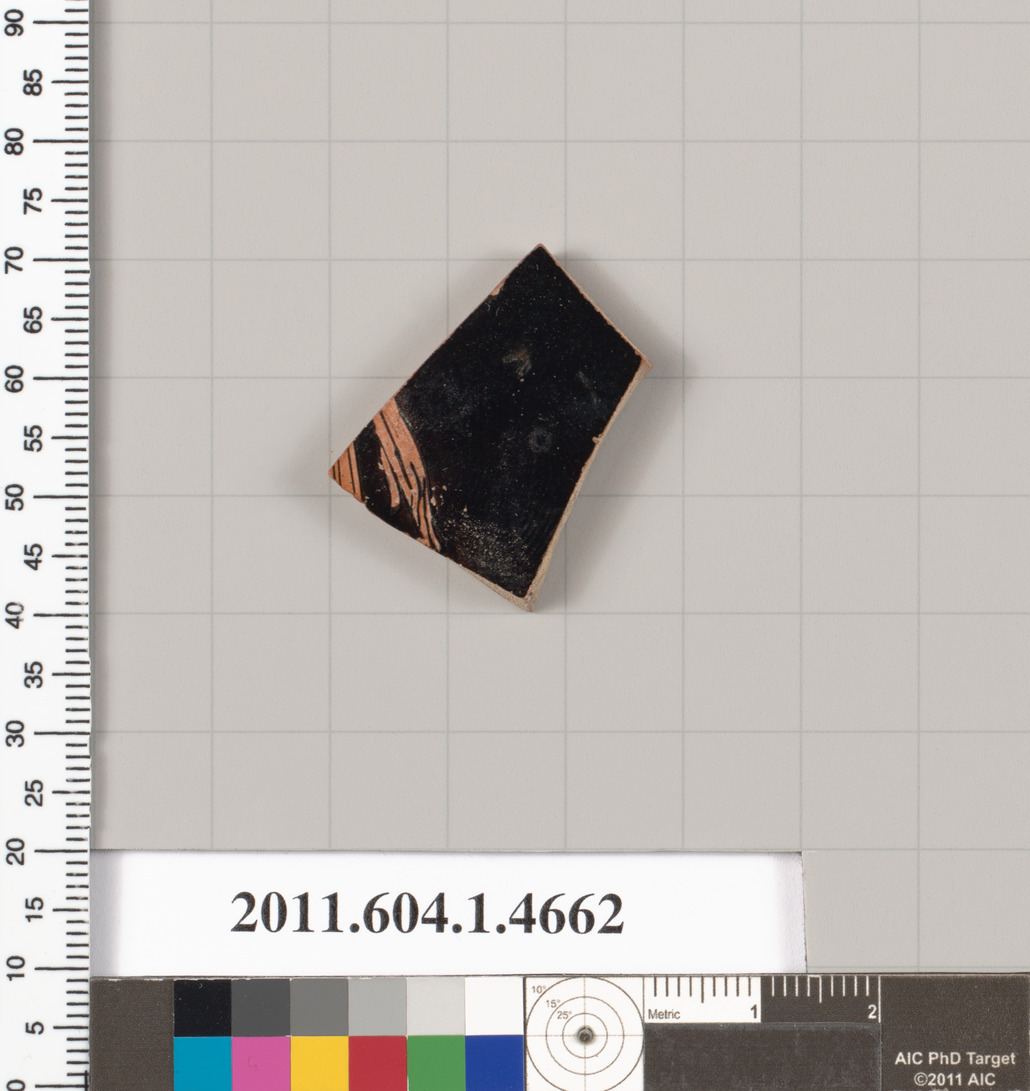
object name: kylix fragment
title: Terracotta fragment of a kylix (drinking cup)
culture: greek, attic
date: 520-500 BCE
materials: terracotta